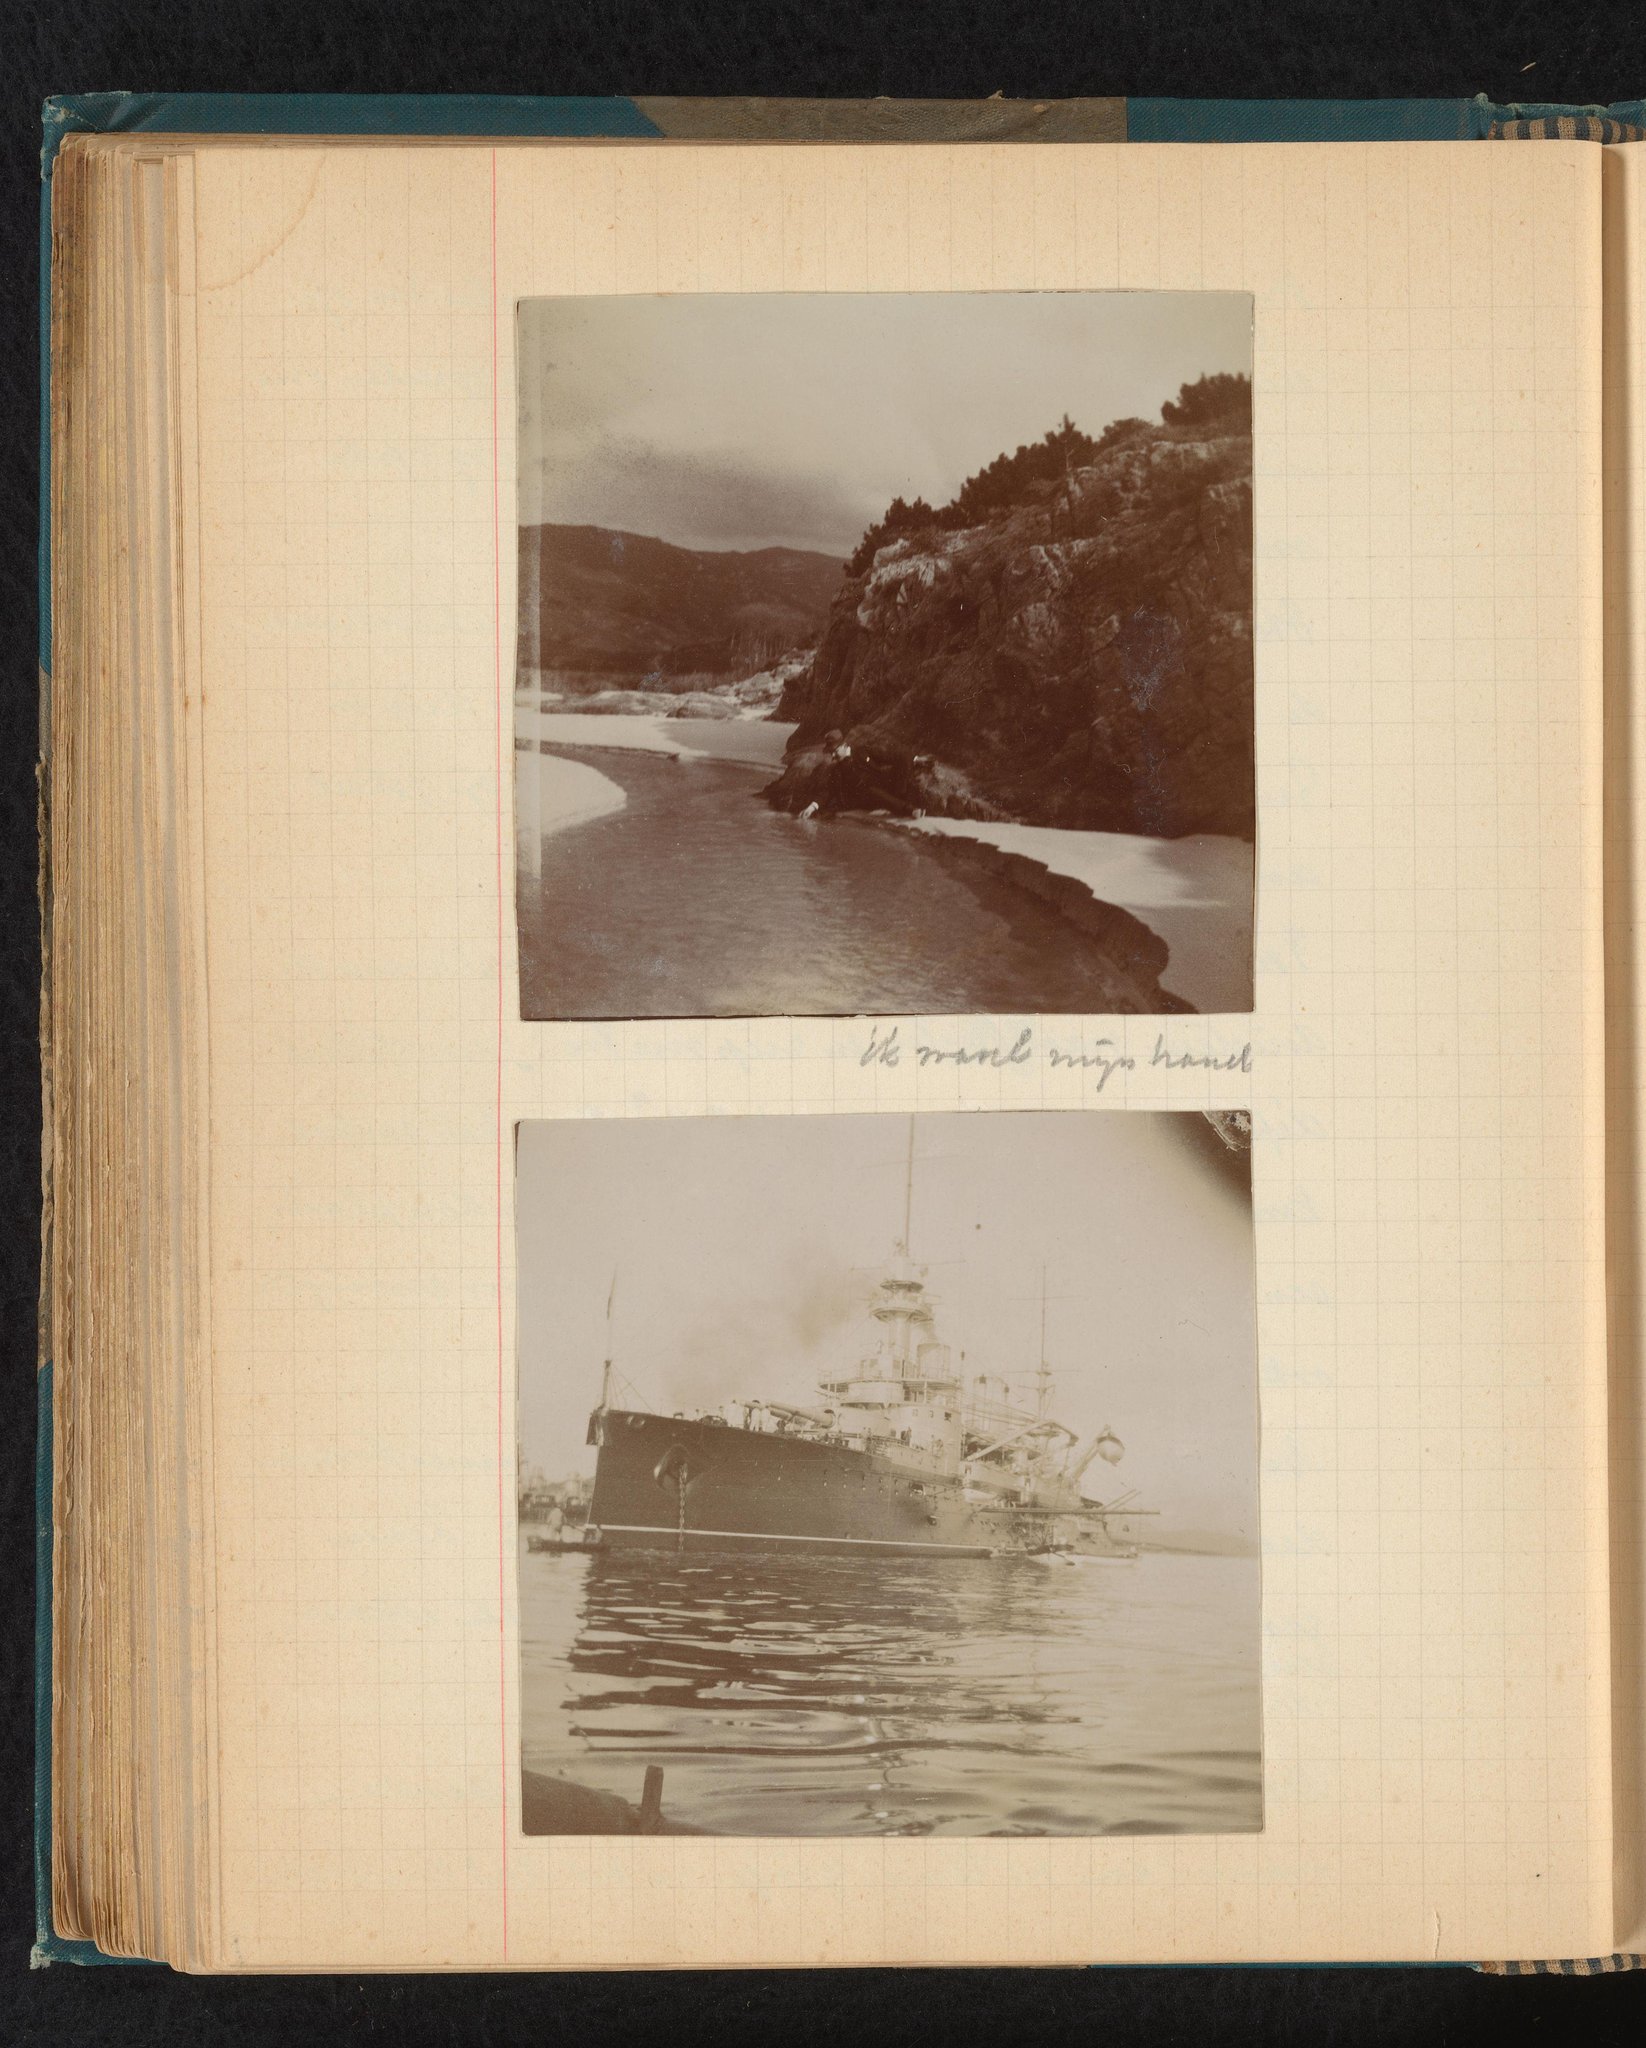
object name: album leaf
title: Theodore van Lelyveld knielend bij een beek met zijn hand in het water en een stoomboot te water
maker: théodore van lelyveld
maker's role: painter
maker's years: 1867-1954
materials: paper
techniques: daylight paper print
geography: chiavari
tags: the hague, painter, théodore van lelyveld, historical persons, brook, steamship, motorship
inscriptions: inscription: ‘ik [...] mijn hand’